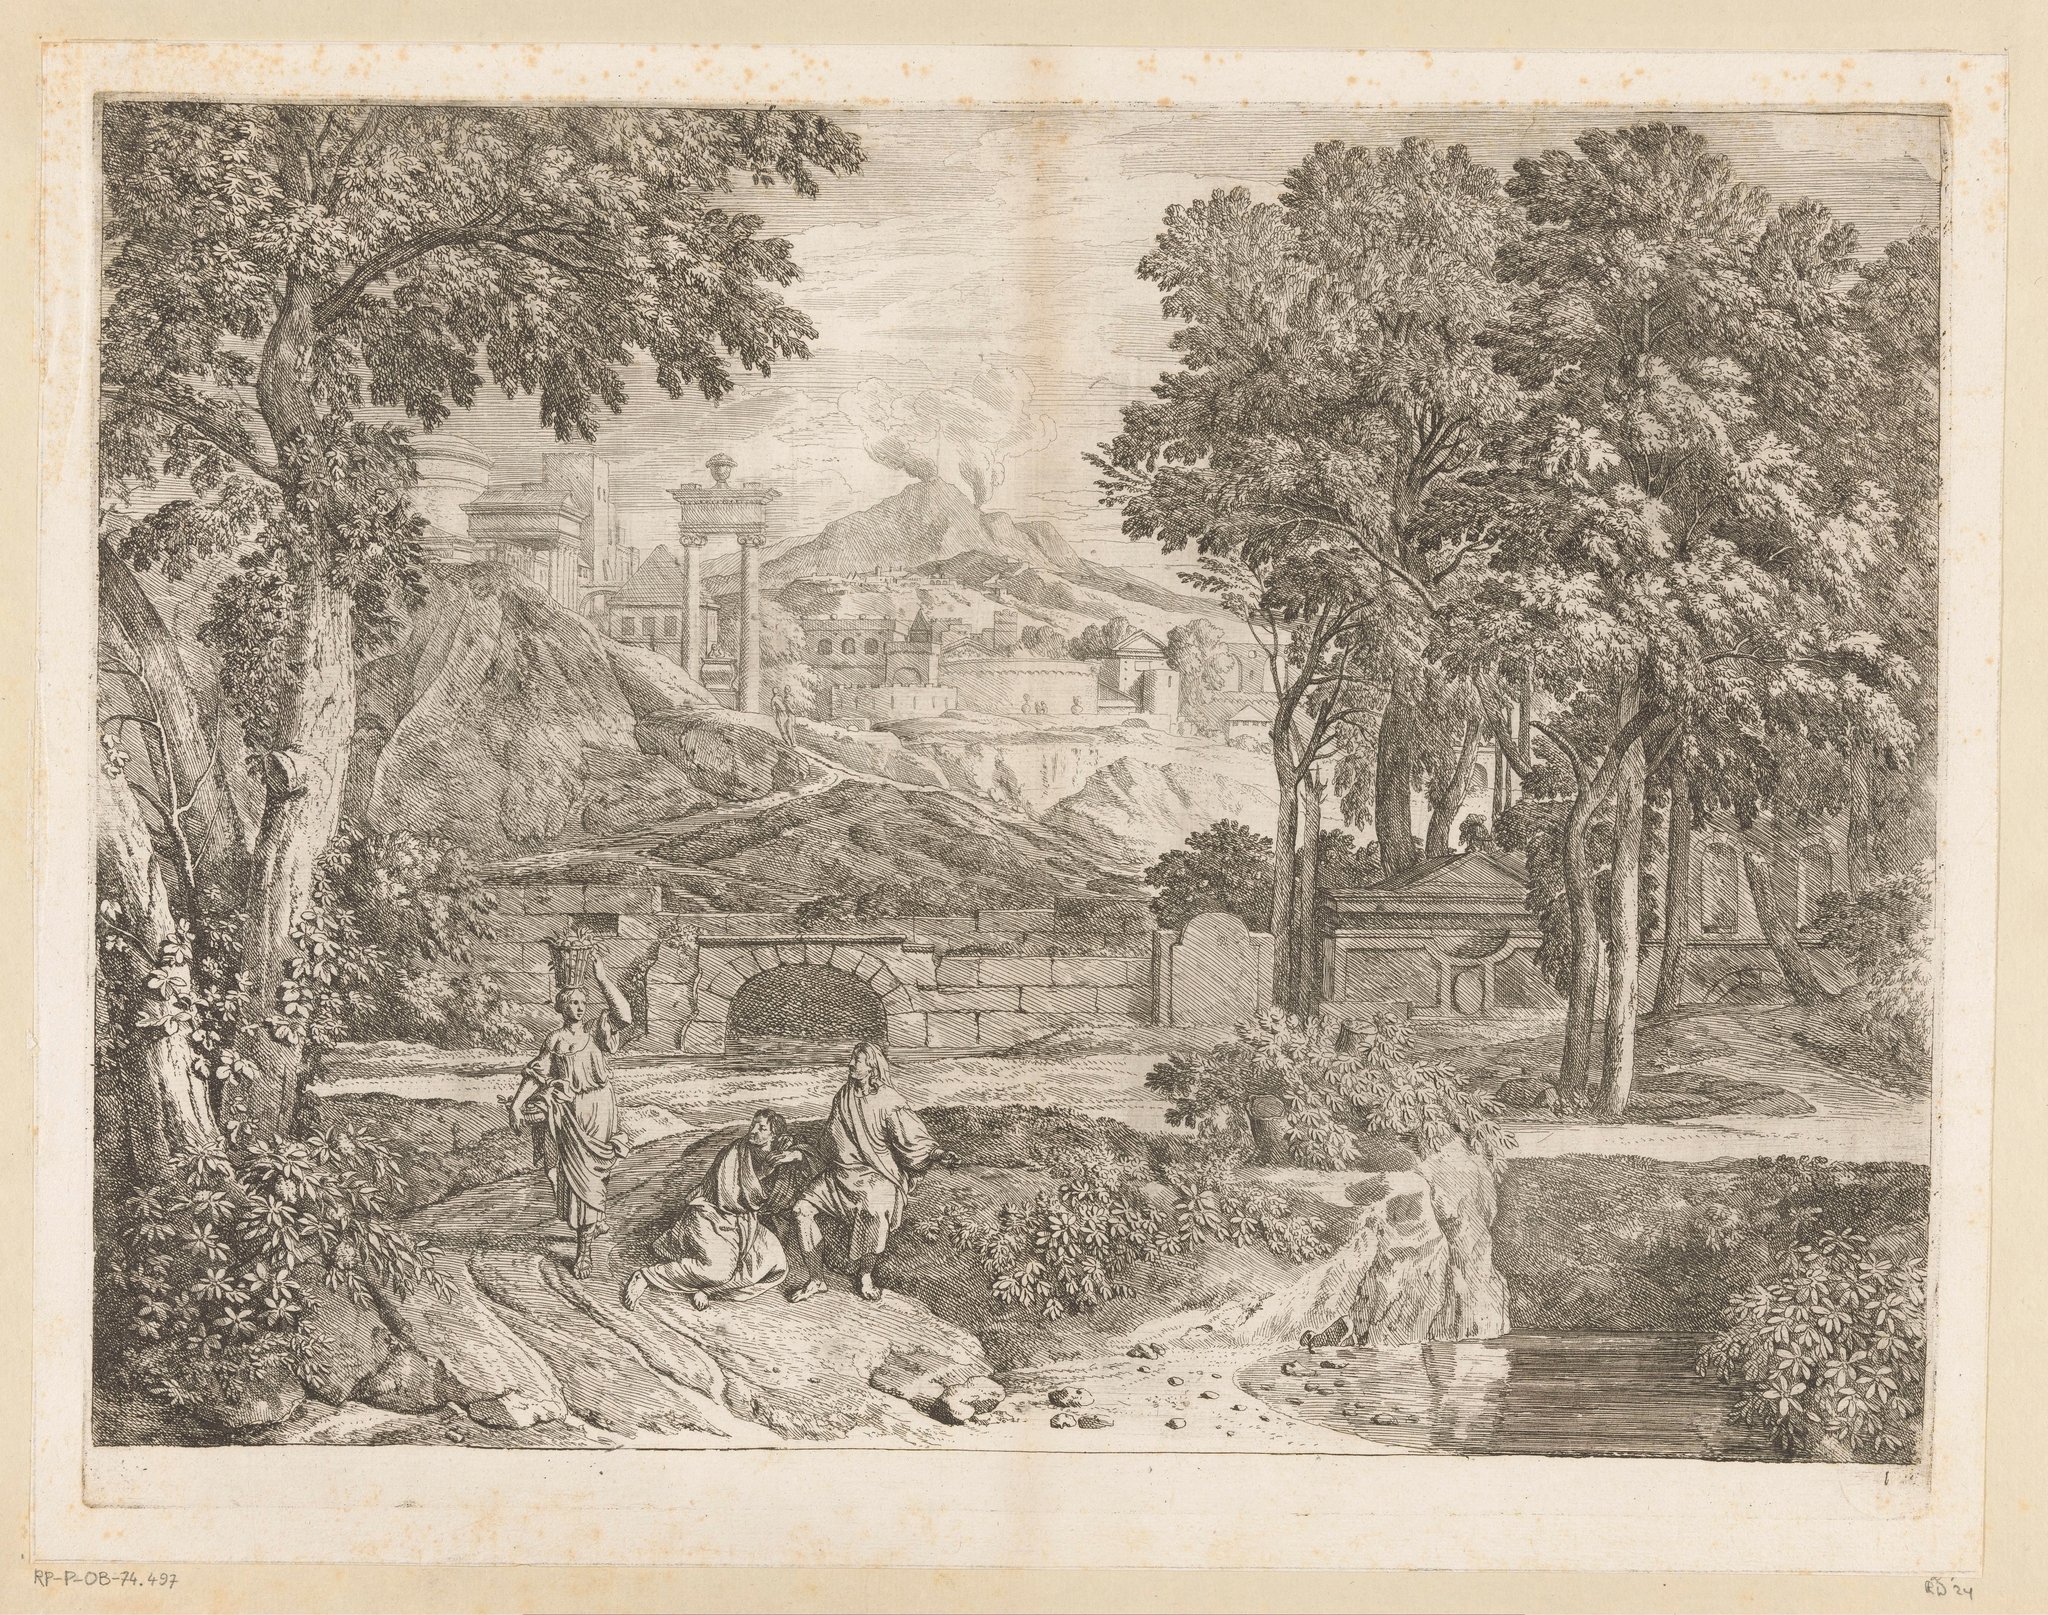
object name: print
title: Arcadisch landschap met twee mannen en een fruit-dragende vrouw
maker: théodore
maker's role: print maker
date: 1690-1730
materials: paper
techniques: etching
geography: france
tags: landscapes in the temperate zone - hh - ideal landscapes, carrying something in basket, bag, rucksack, etc., volcano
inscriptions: collector's mark: Lugt 240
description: Landschap met twee zittende mannen en een vrouw met twee manden met fruit lopend over een bospad. Op de achtergrond is een stad te zien met daarachter een hoge berg of vulkaan. Genummerd rechtsonder: 1.